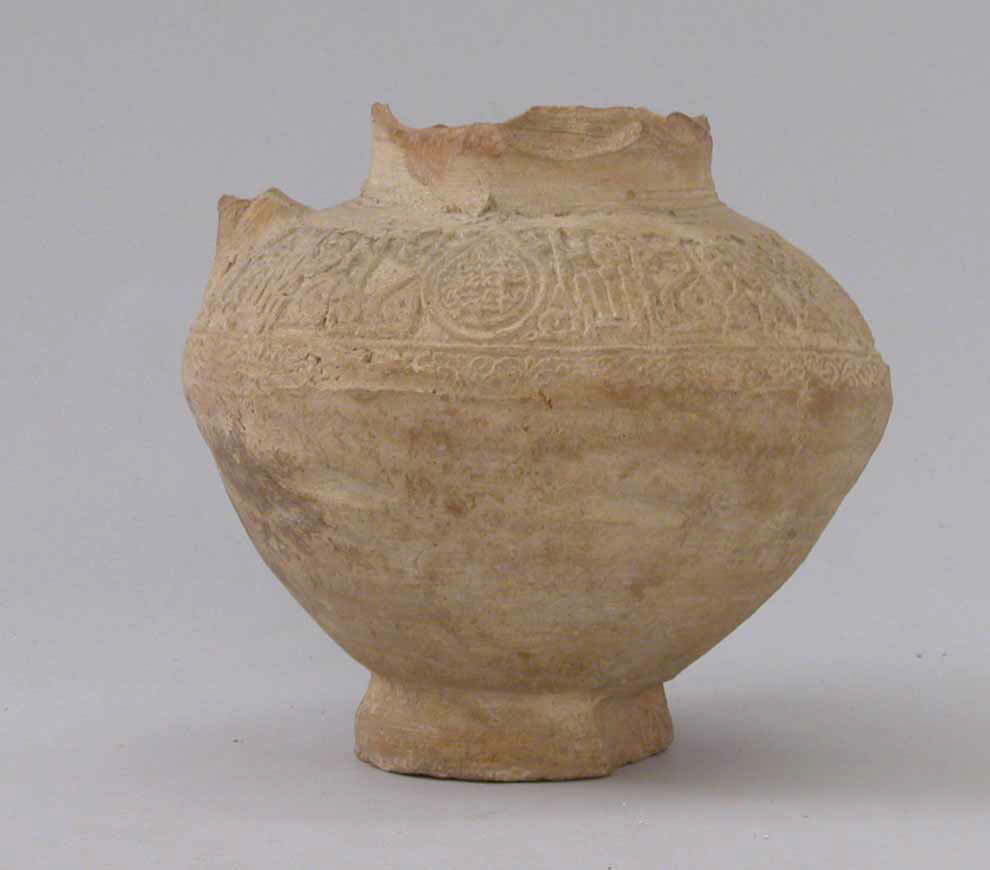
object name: jar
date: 1001-1200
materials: earthenware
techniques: incising, molding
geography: iran